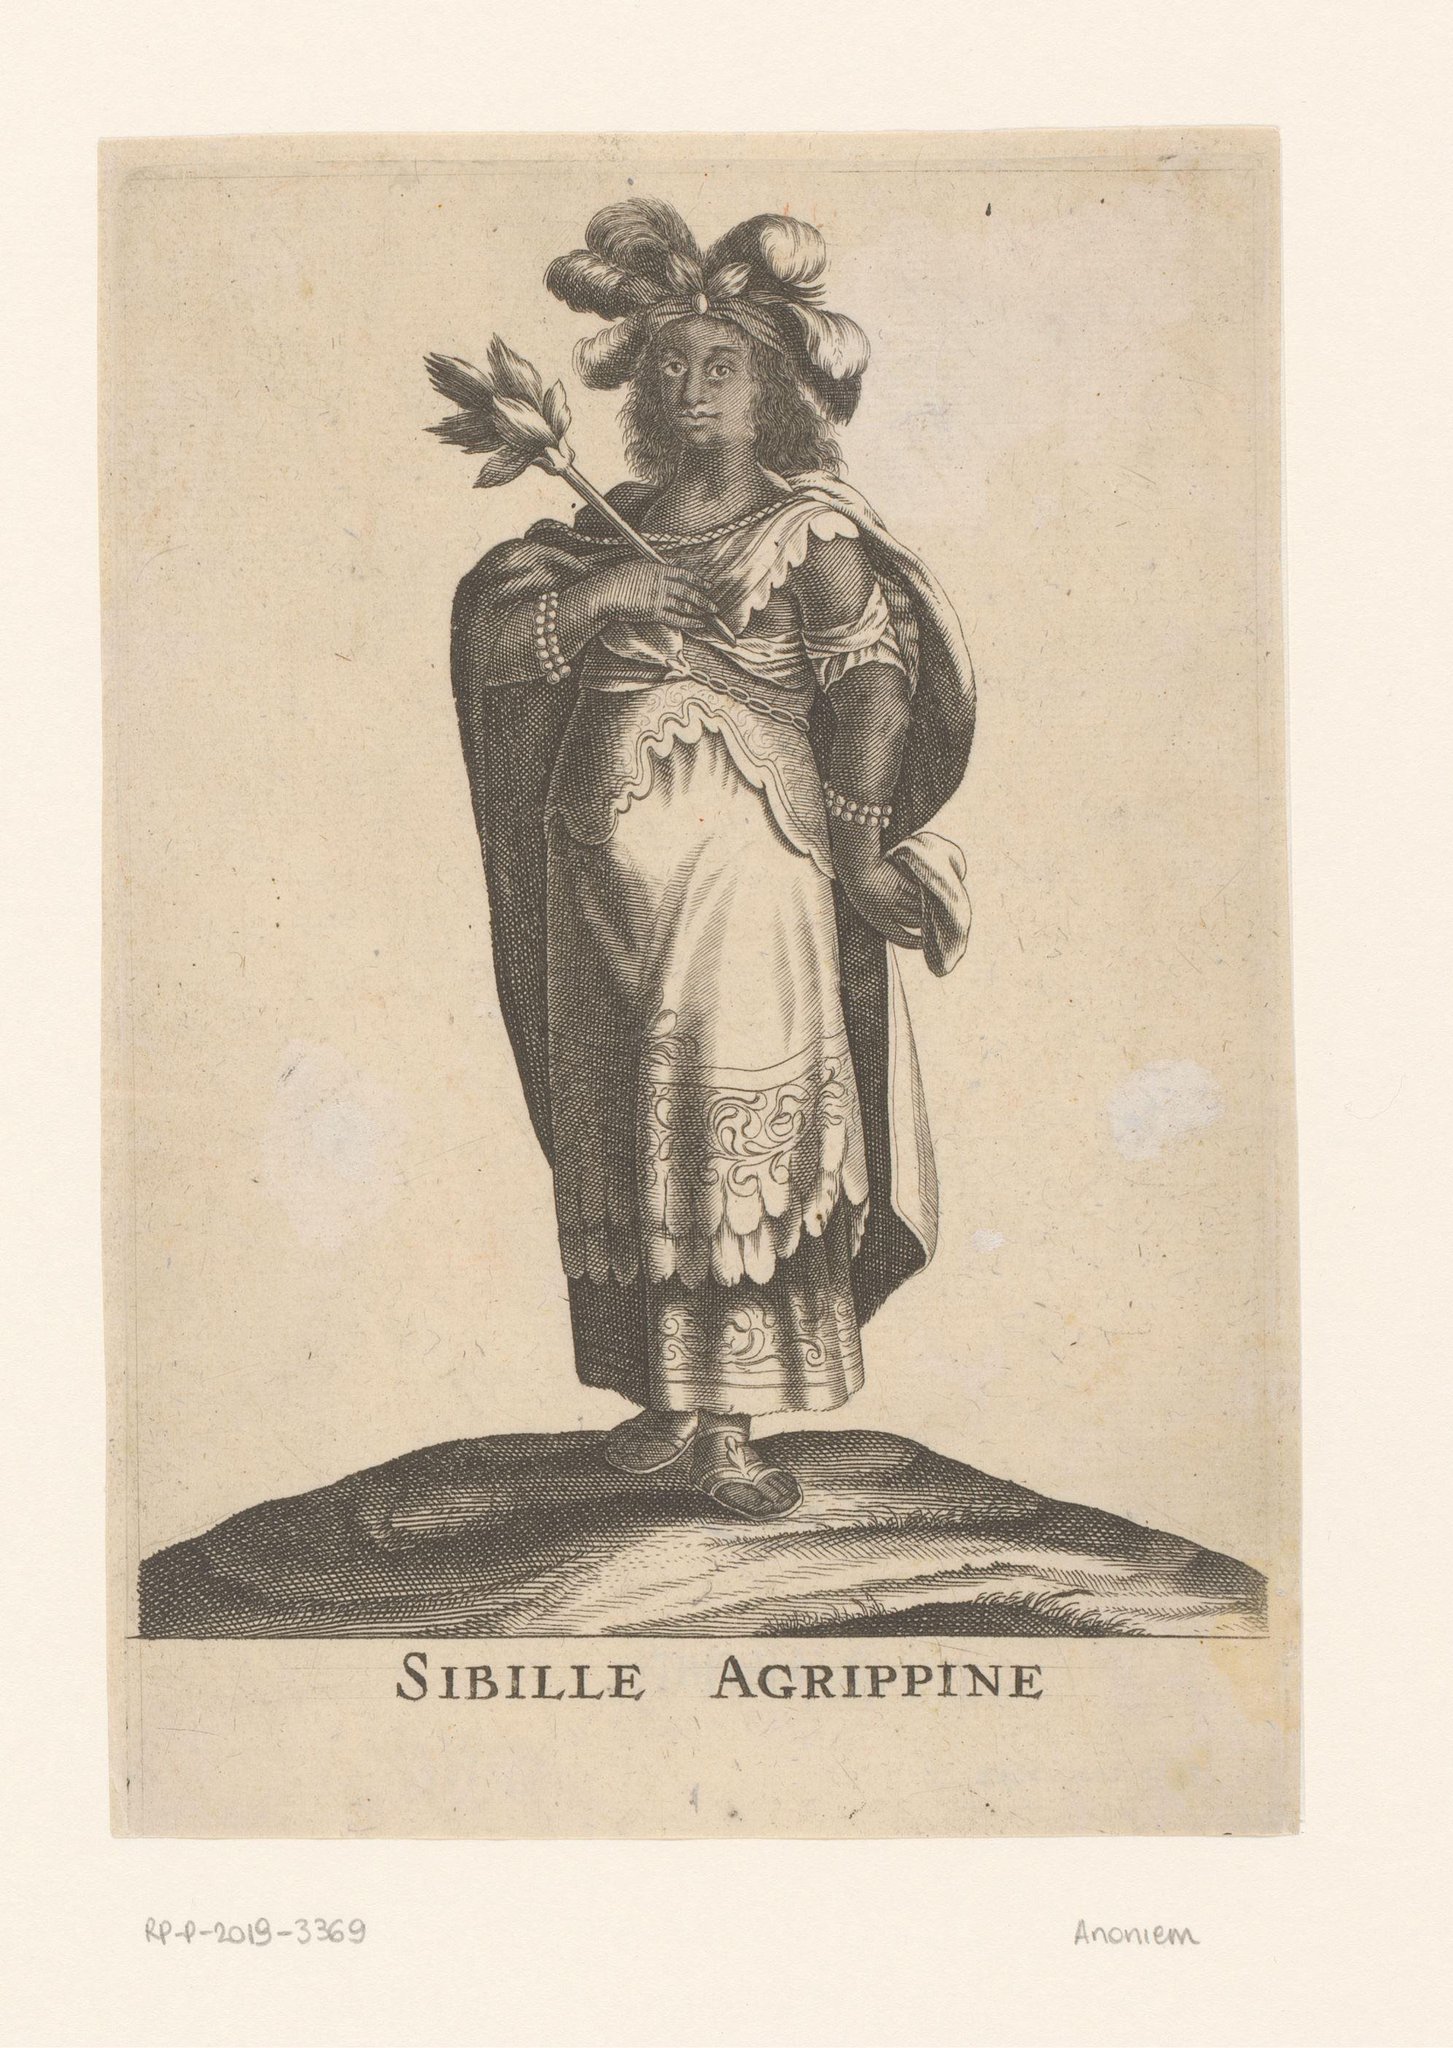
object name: print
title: Sibille Agrippine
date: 1600-1699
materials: paper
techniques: engraving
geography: netherlands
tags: agrippine sibyl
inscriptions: collector's mark: Lugt 2228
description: Maakt mogelijk deel uit van een serie met de twaalf sibillen.